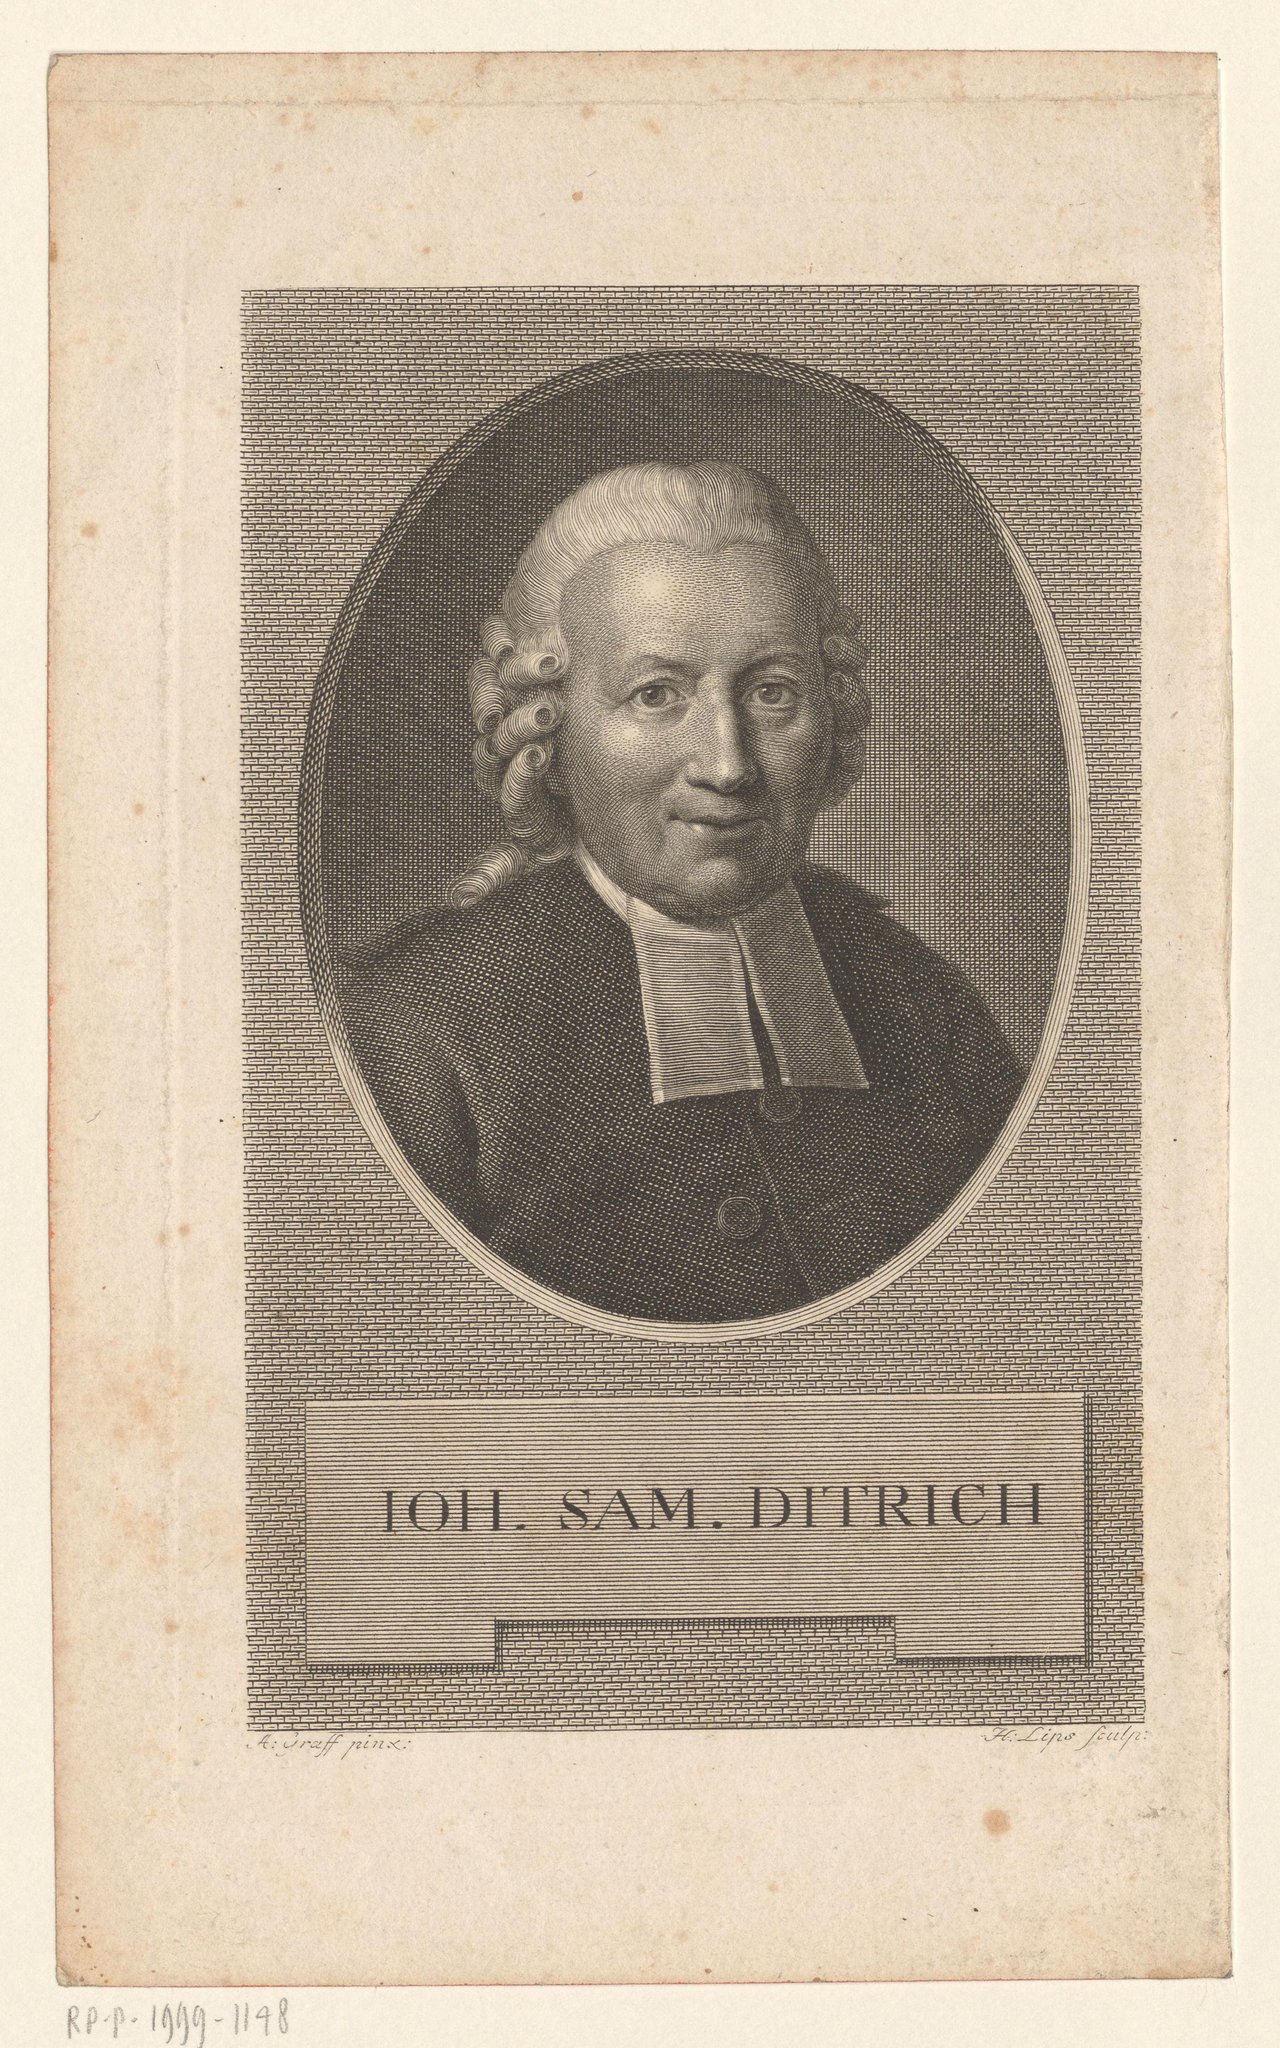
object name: print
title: Portret van Johann Samuel Ditrich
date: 1795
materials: paper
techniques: engraving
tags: berlin, theologian, historical persons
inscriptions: collector's mark: Lugt 2228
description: Prent waarschijnlijk uit: Teller, Wilhelm Abraham ed.. Neues Magazin für Prediger, Züllichau en Freystadt: Friedrich Frommann,1795, dl. 4.